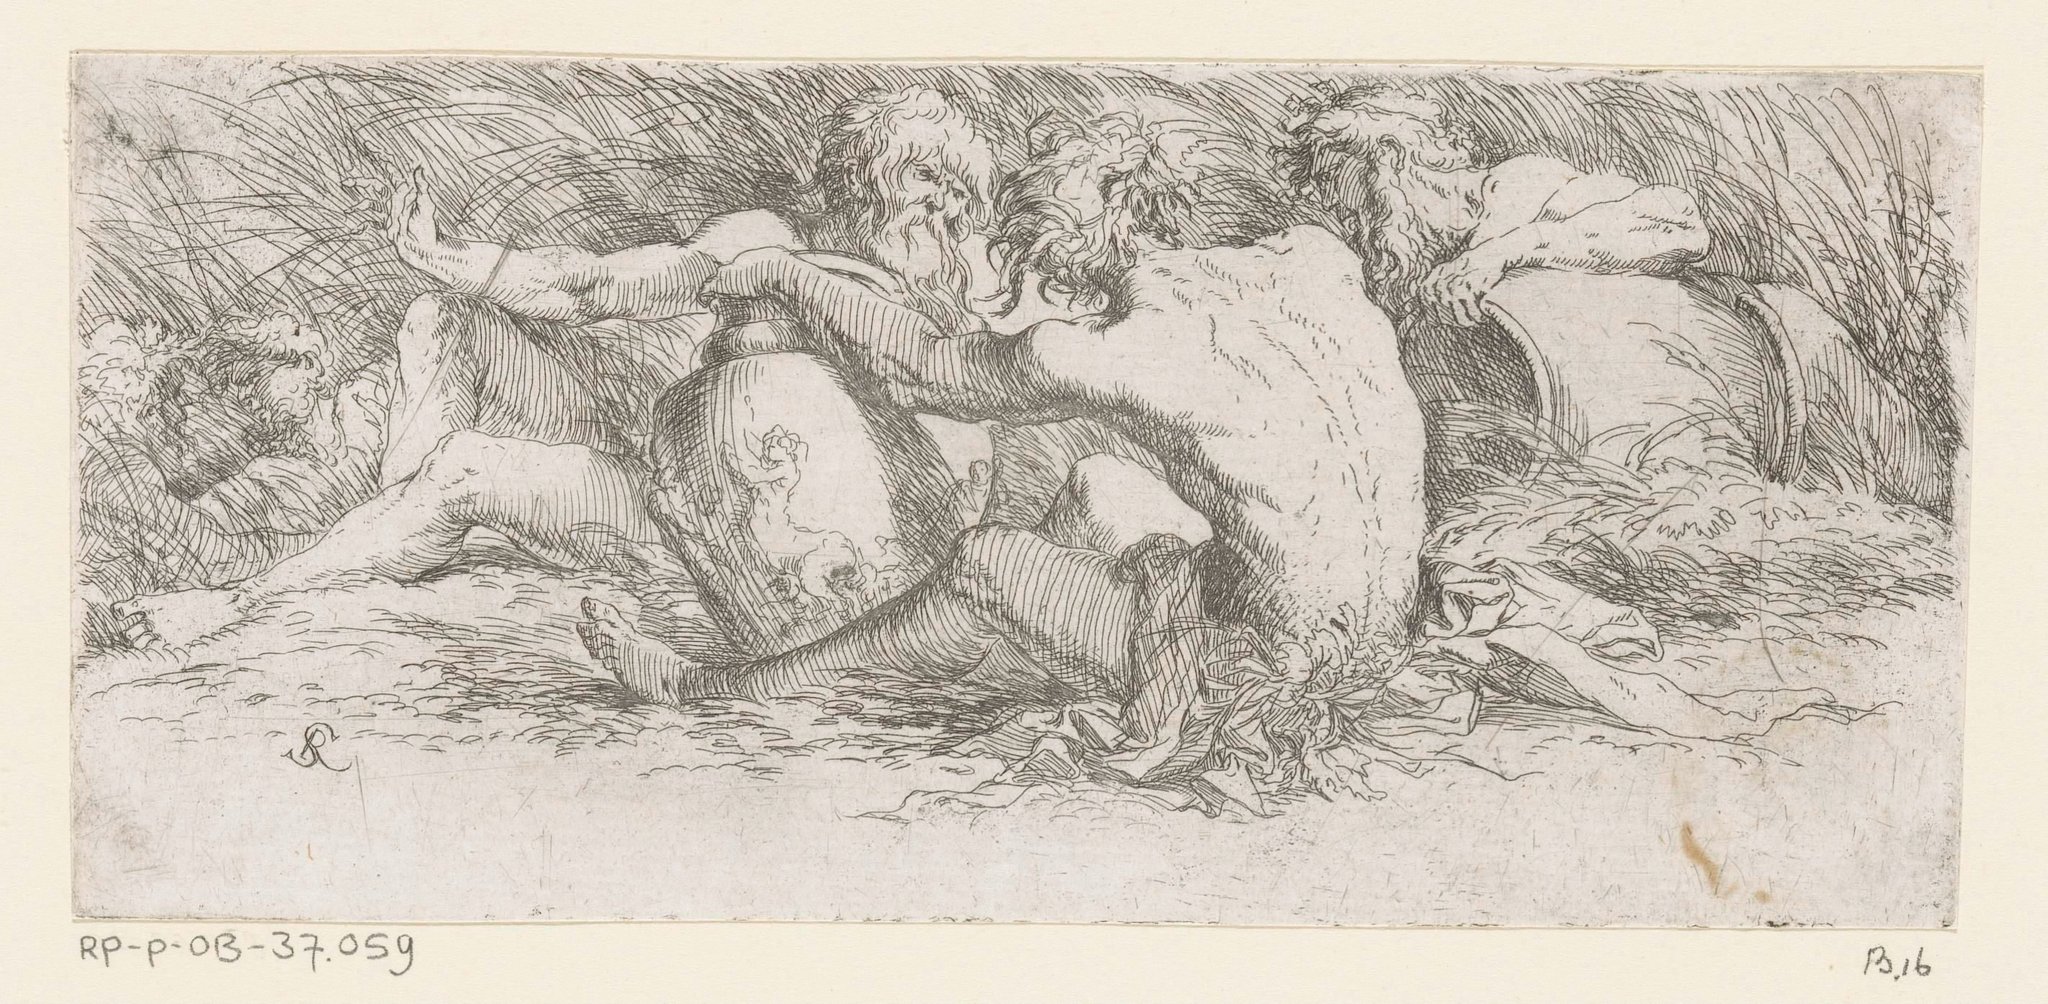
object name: print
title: Drie riviergoden met urnen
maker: salvator rosa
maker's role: draughtsman, painter, print maker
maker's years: 1615-1673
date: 1660-1661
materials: paper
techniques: drypoint, etching, intaglio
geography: italy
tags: river-gods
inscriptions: collector's mark: Lugt 240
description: Drie zittende riviergoden met urnen. Links op de achtergrond nog twee riviergoden.